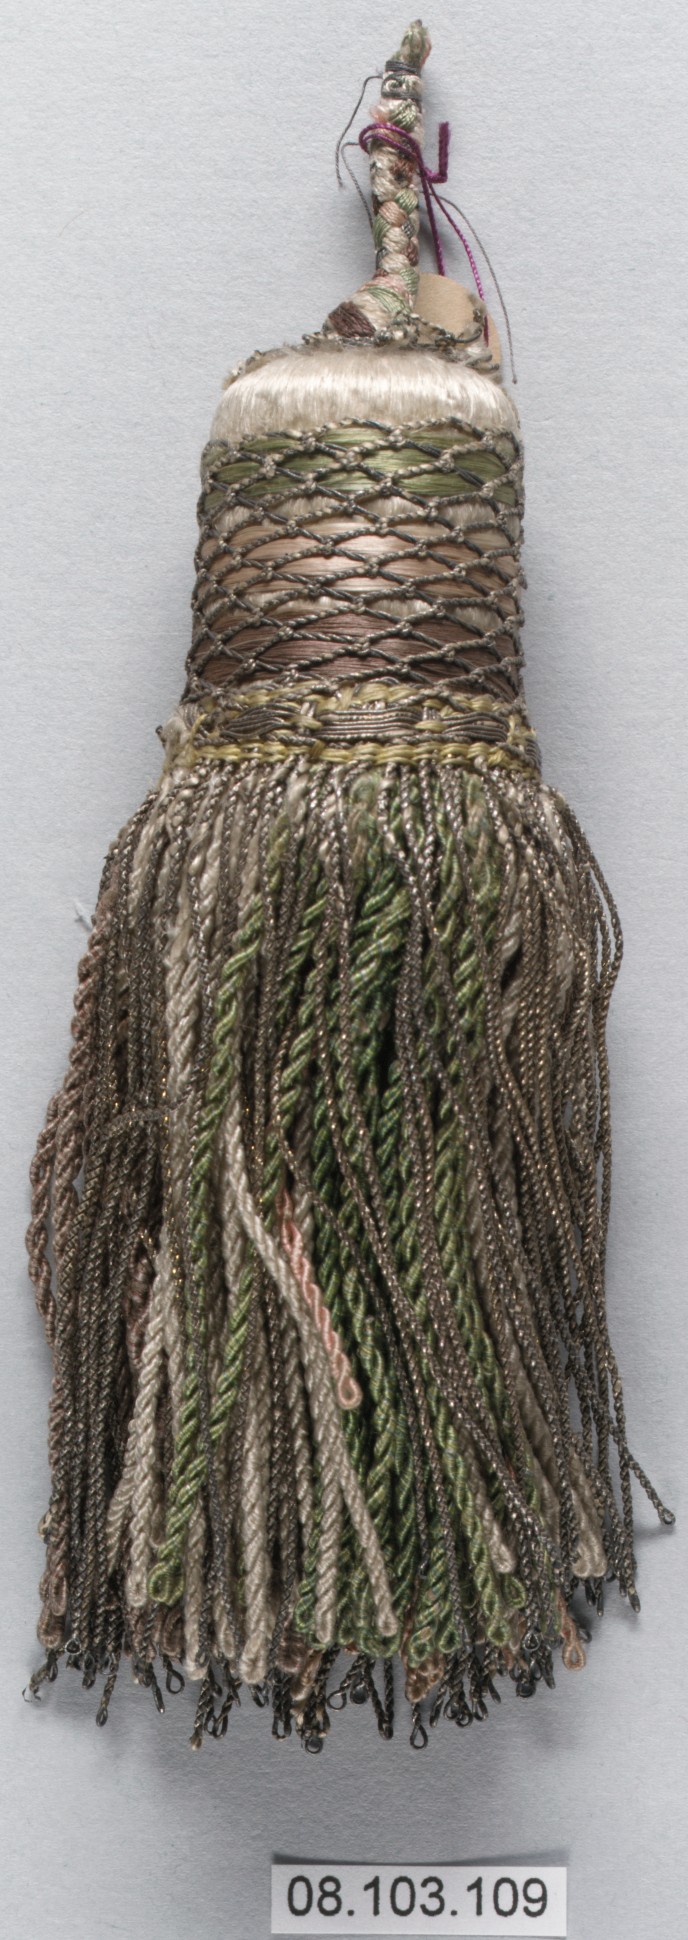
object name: tassel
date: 1701-1800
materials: metal thread, silk